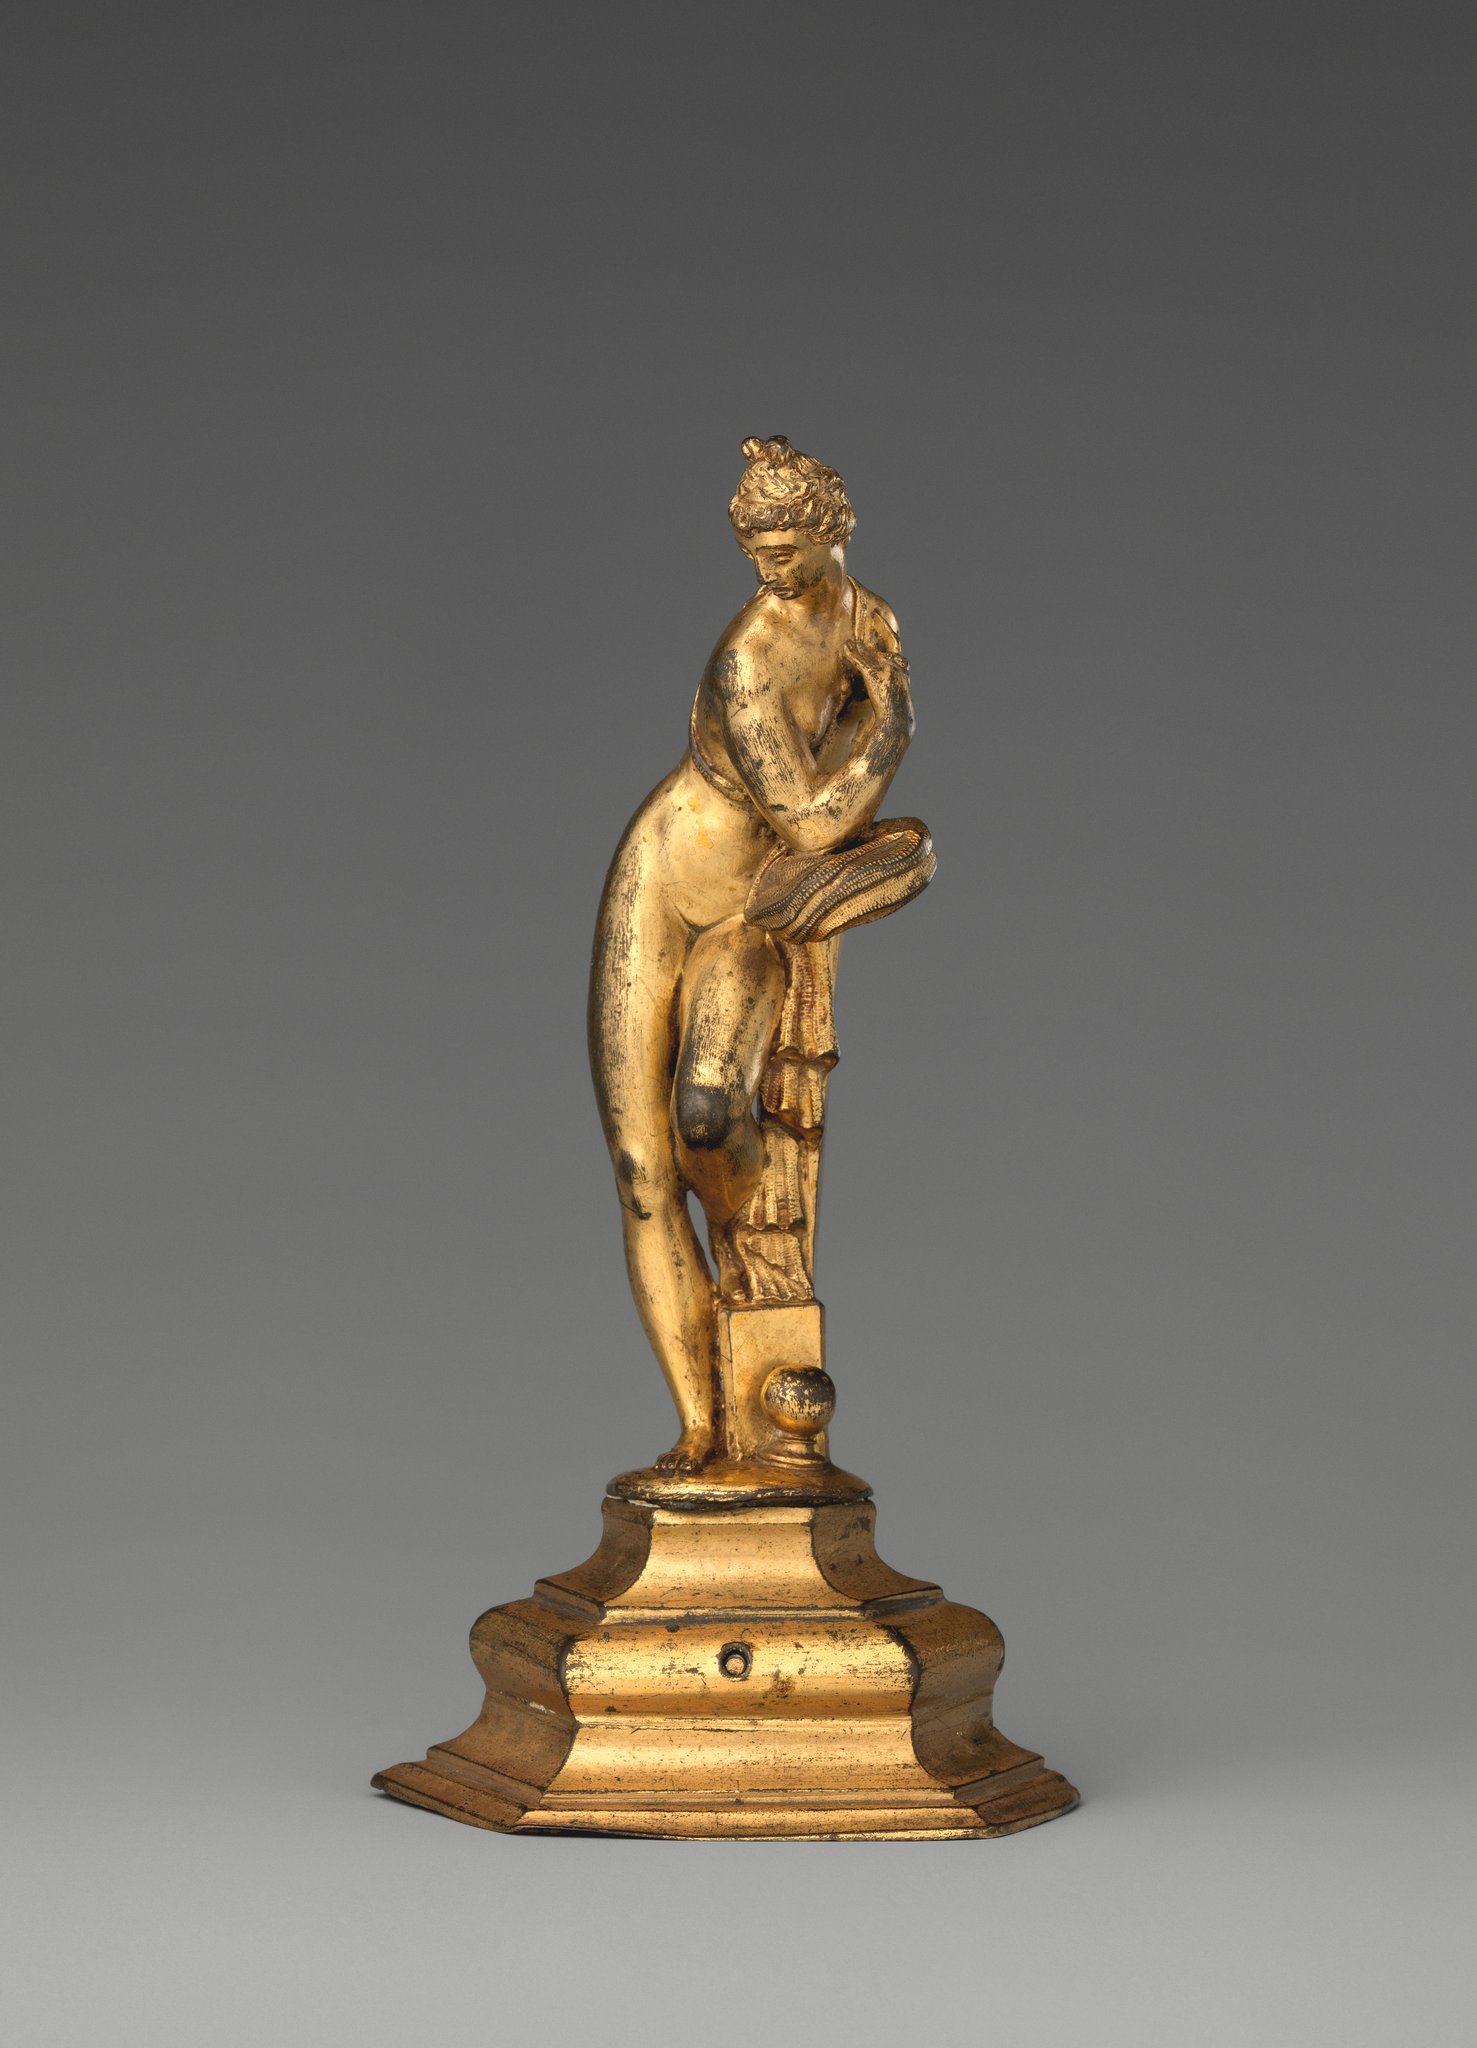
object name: statuette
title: Venus Urania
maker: giambologna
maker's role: artist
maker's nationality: netherlandish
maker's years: 1529-1608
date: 1601-1800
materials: bronze, gilt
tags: women